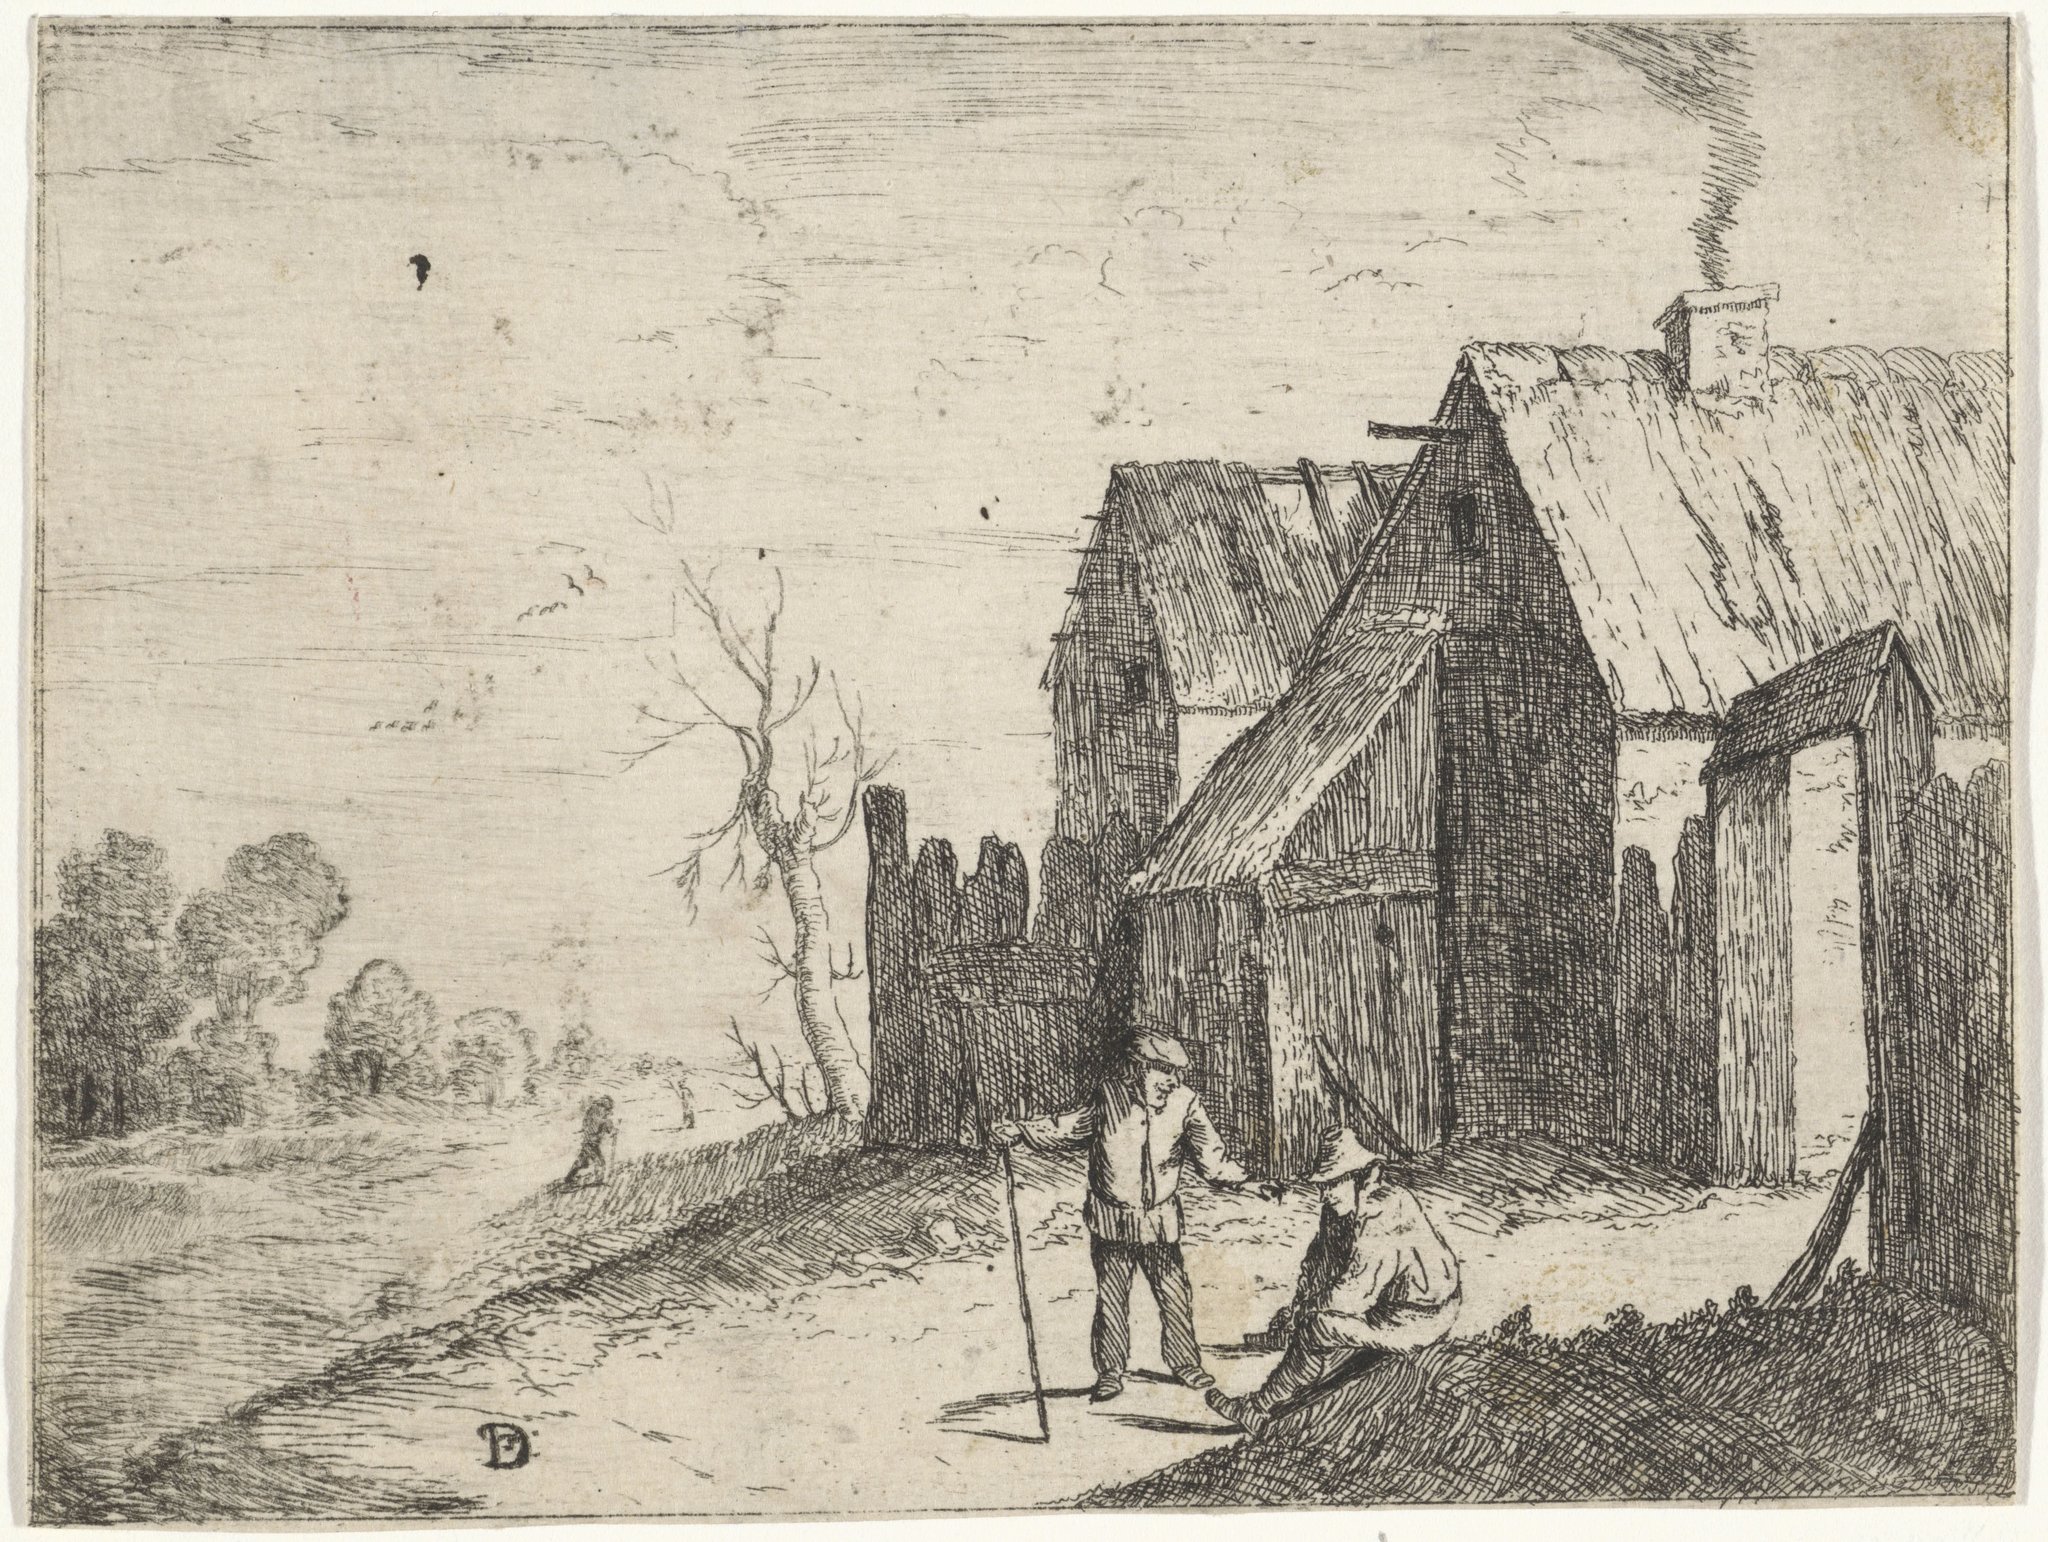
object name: print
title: Twee boeren in gesprek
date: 1700-1799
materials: paper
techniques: etching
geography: low countries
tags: gate, entrance, conversation, dialogue; conversation piece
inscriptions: collector's mark: Lugt 2228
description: Twee boeren in gesprek bij twee woningen. Rechts een poort in het hek.